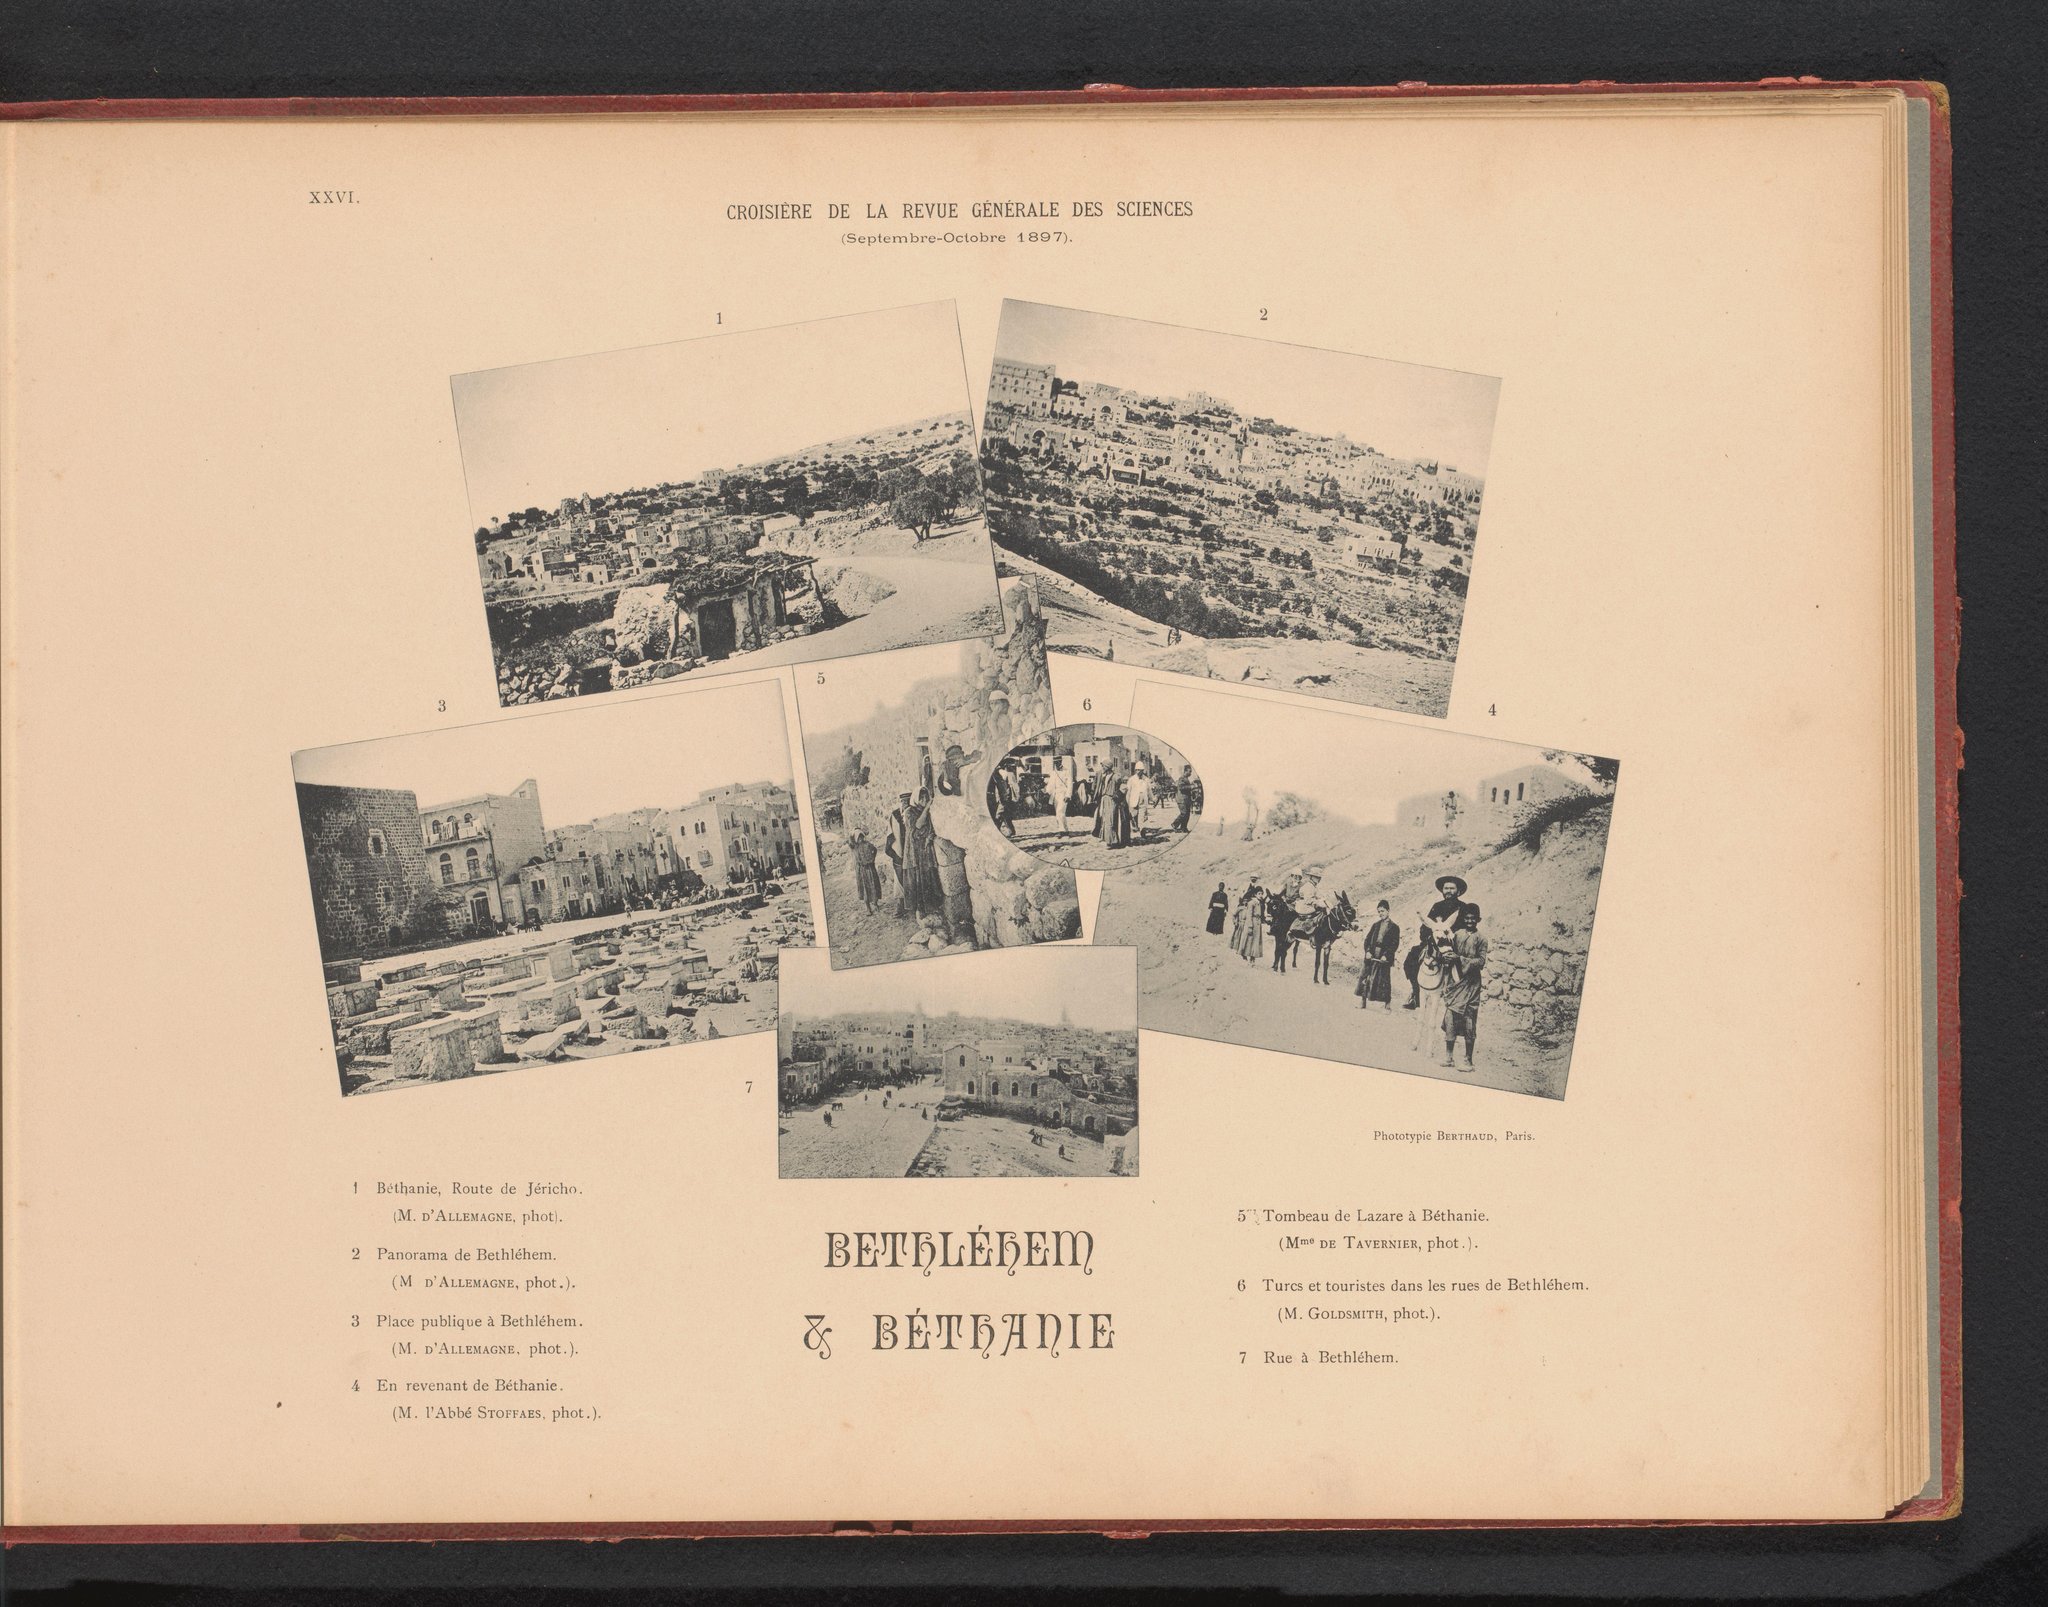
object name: page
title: Bethléhem & Béthanie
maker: michel berthaud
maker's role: publisher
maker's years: 1845-1912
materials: paper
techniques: photograph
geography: bethlehem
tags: street, prospect of city, town panorama, silhouette of city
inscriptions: inscription: ‘1 Bethanië, Route de Jéricho./ (M. d'Allemagne, phot.)./ 2 Panorama de Bethléhem./ (M. d'Allemagne, phot.)./ 3 Place publique à Bethléhem./ (M. d'Allemagne, phot.)./ 4 En revenant de Béthanie./ (M. l'Abbé Stoffaes, phot.)./ 5 Tombeau de Lazare à Bethanie./ (Mme de Tavernier, phot.)./ 6 Turcs et touristes dans les rues de Bethléhem./ (M. Goldsmith, phot.)./ 7 Rue à Bethléhem.’, number: ‘XXVI.’